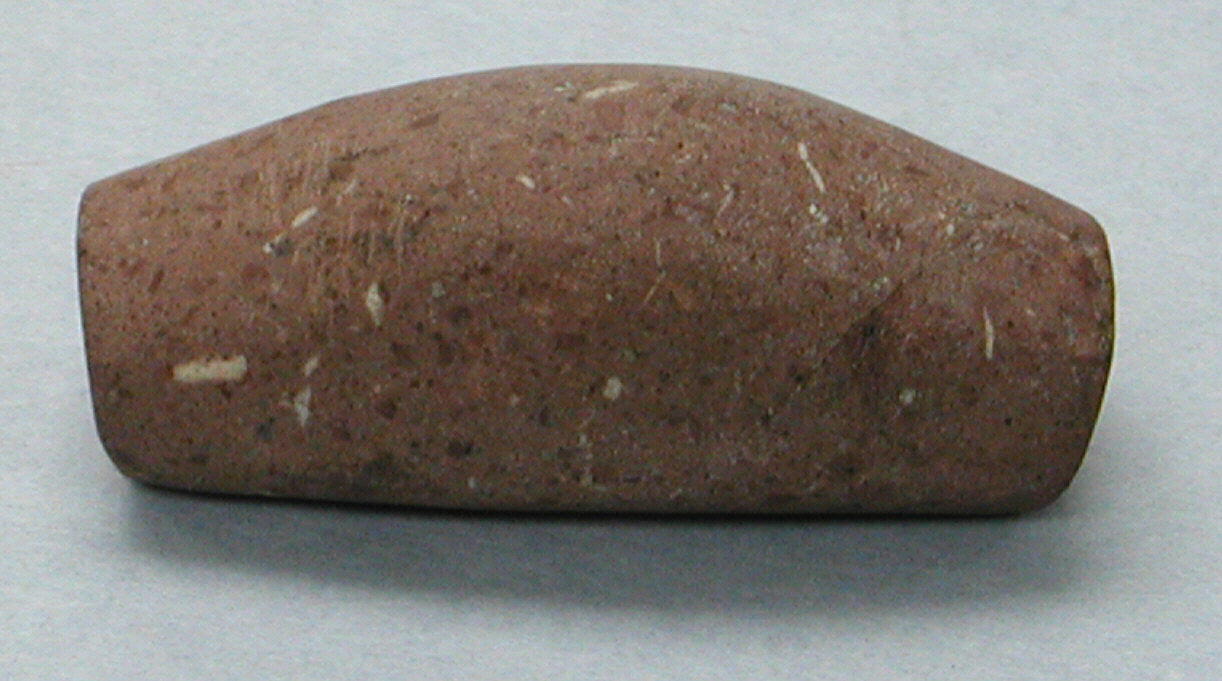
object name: ritual stone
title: Stone Pulidor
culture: mexican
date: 1501-1600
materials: stone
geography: mexico